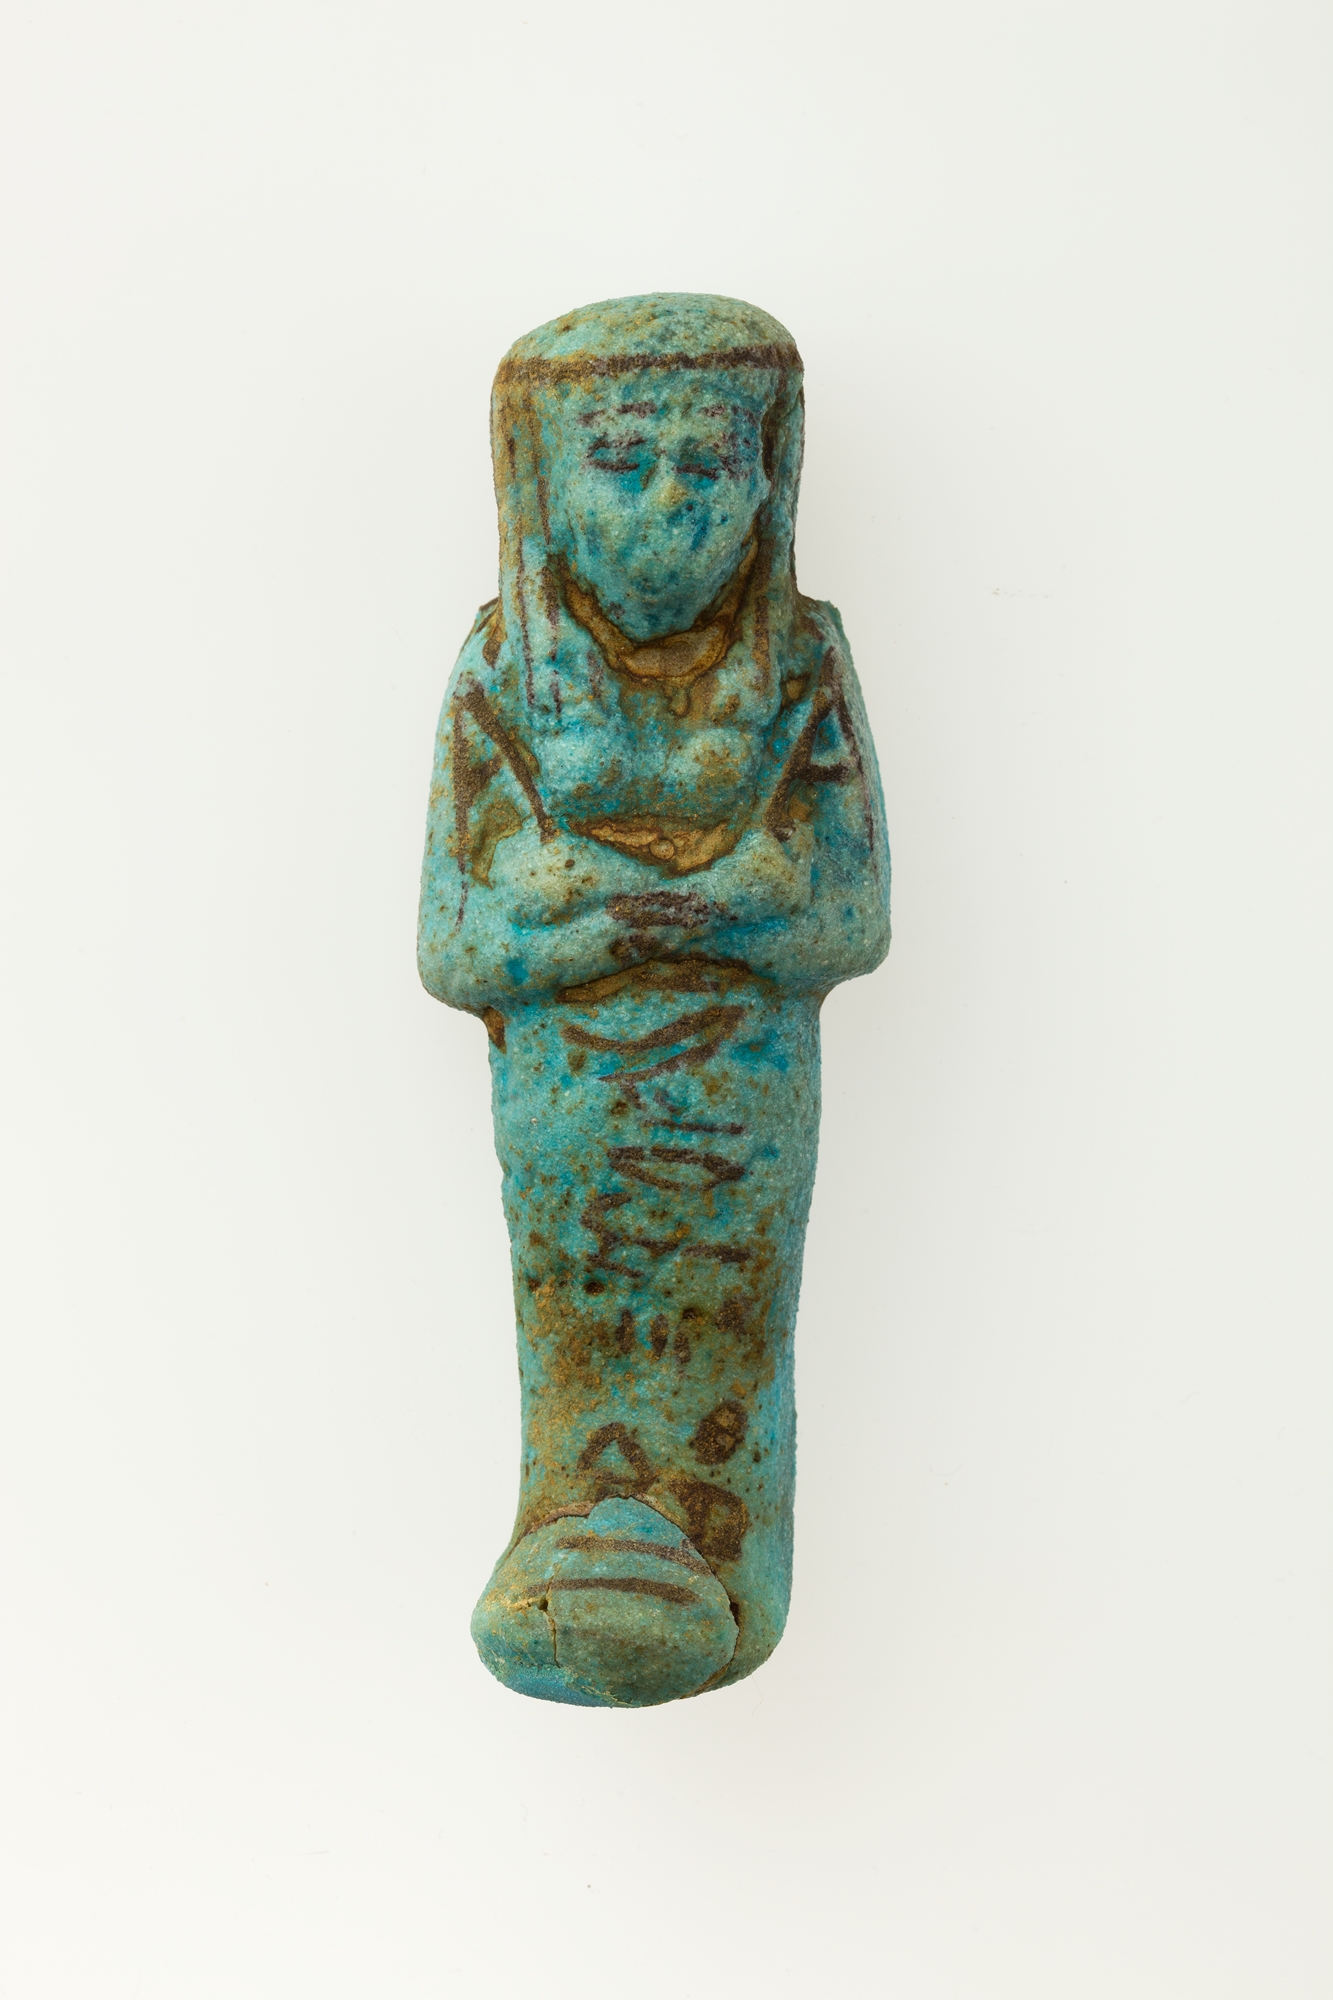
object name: shabti, henettawy c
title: Worker Shabti of Henettawy (C), Daughter of Isetemkheb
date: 990-970 BCE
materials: faience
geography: egypt